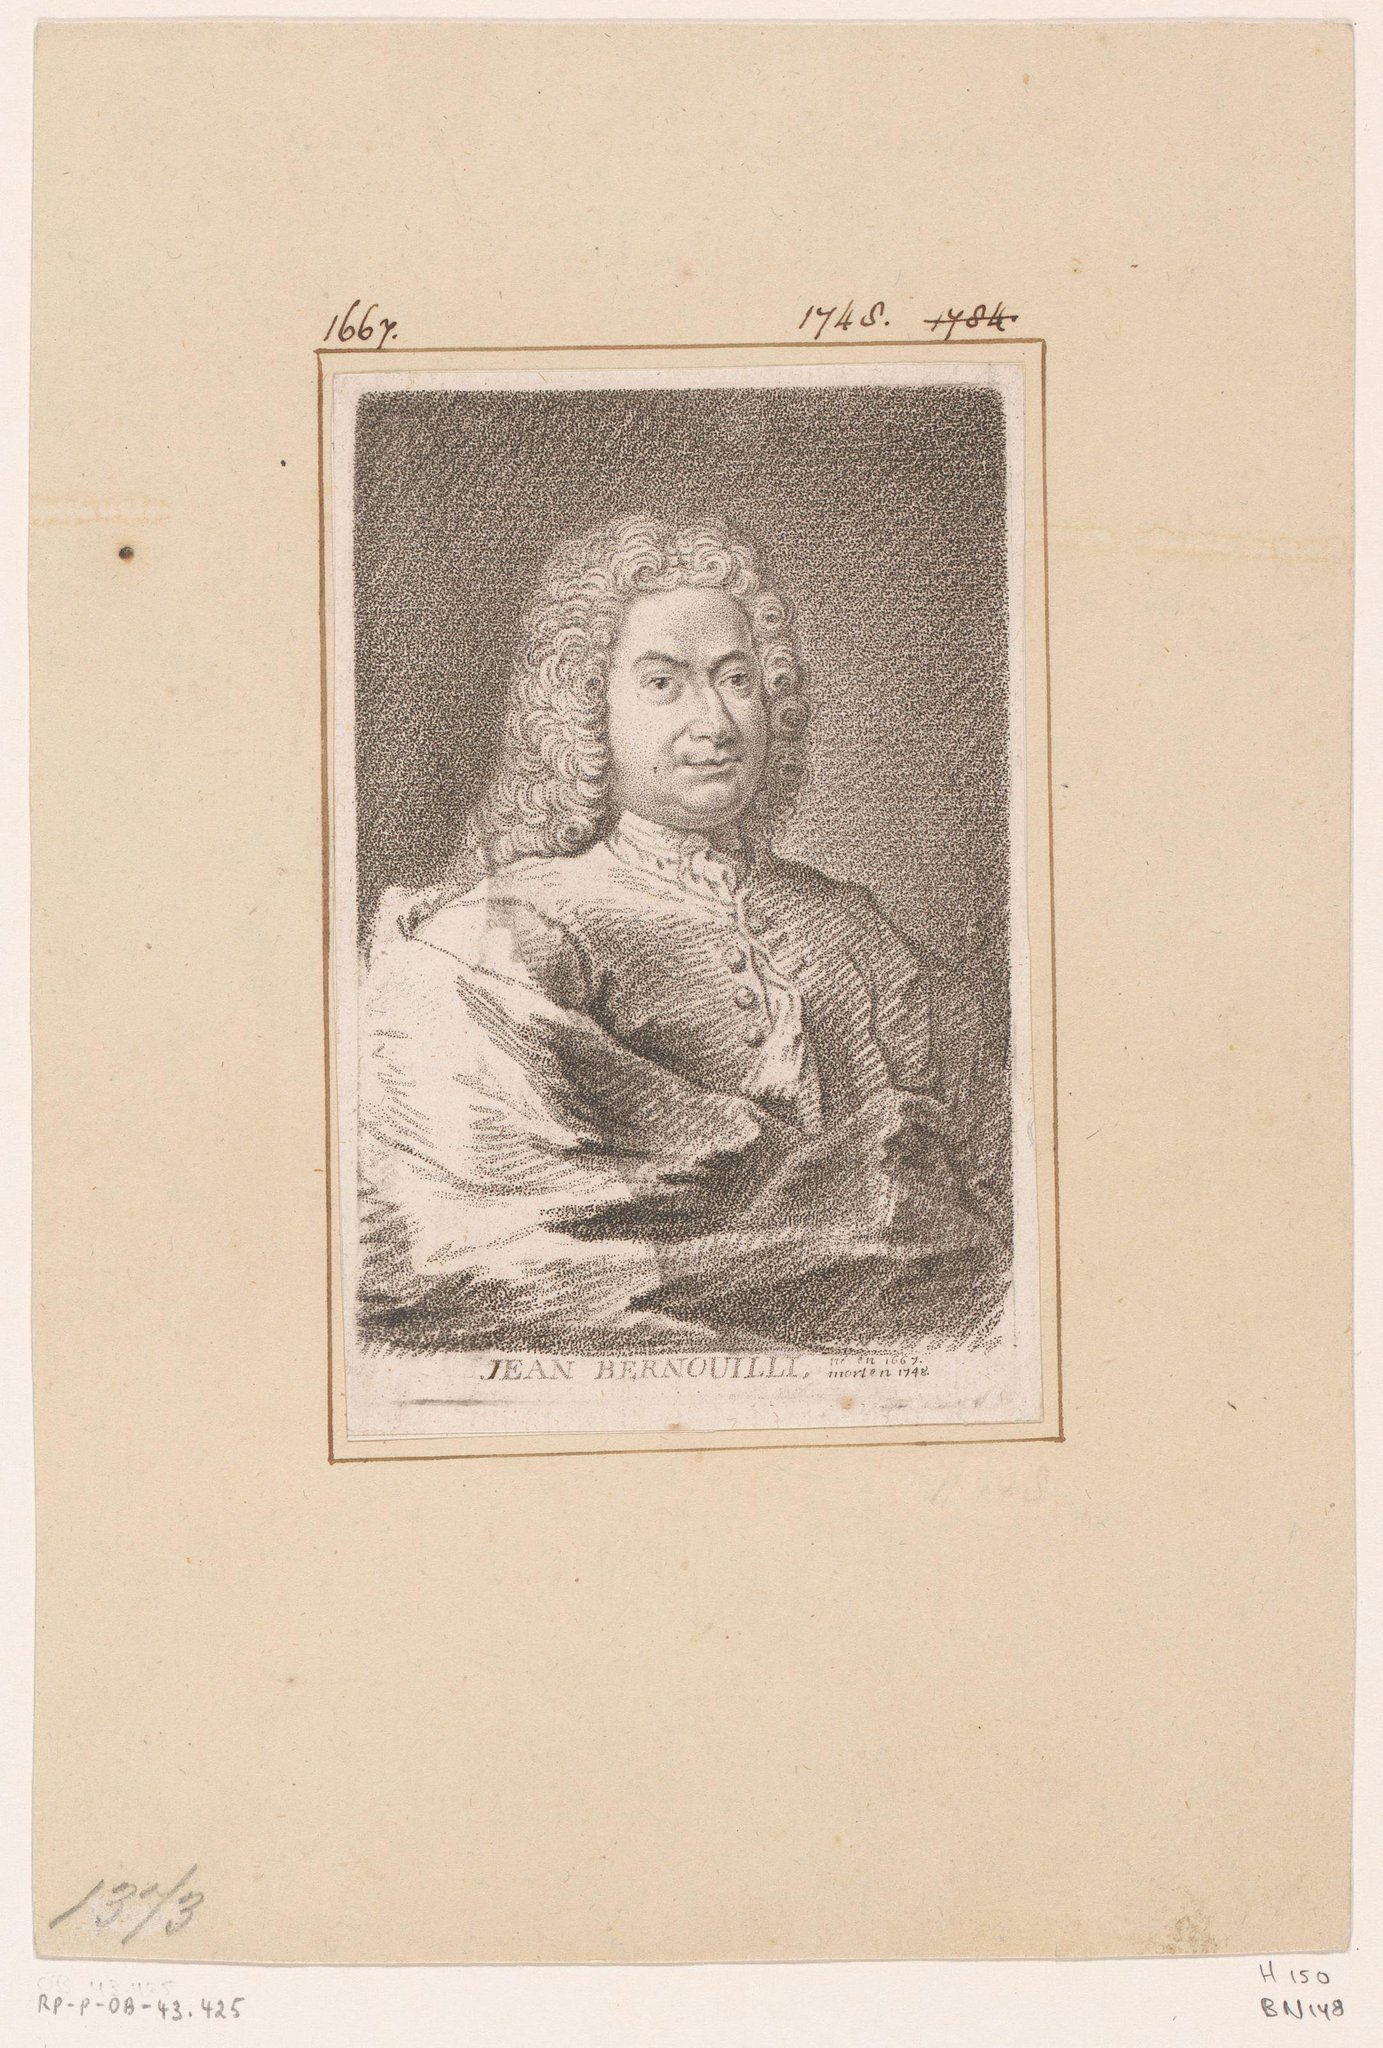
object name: book illustration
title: Jean Bernoulli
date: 1760-1769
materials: paper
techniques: printmaking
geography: france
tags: historical persons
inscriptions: collector's mark: Lugt 2228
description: Prent uit: Saverien, Alexandre. L'Histoire des Philosophes modernes, avec leur portrait gravé dans le goût du crayon, d'apres les desseins des plus grands peintres. Parijs: Jean Charles François, 1760-1761, dl. 4.